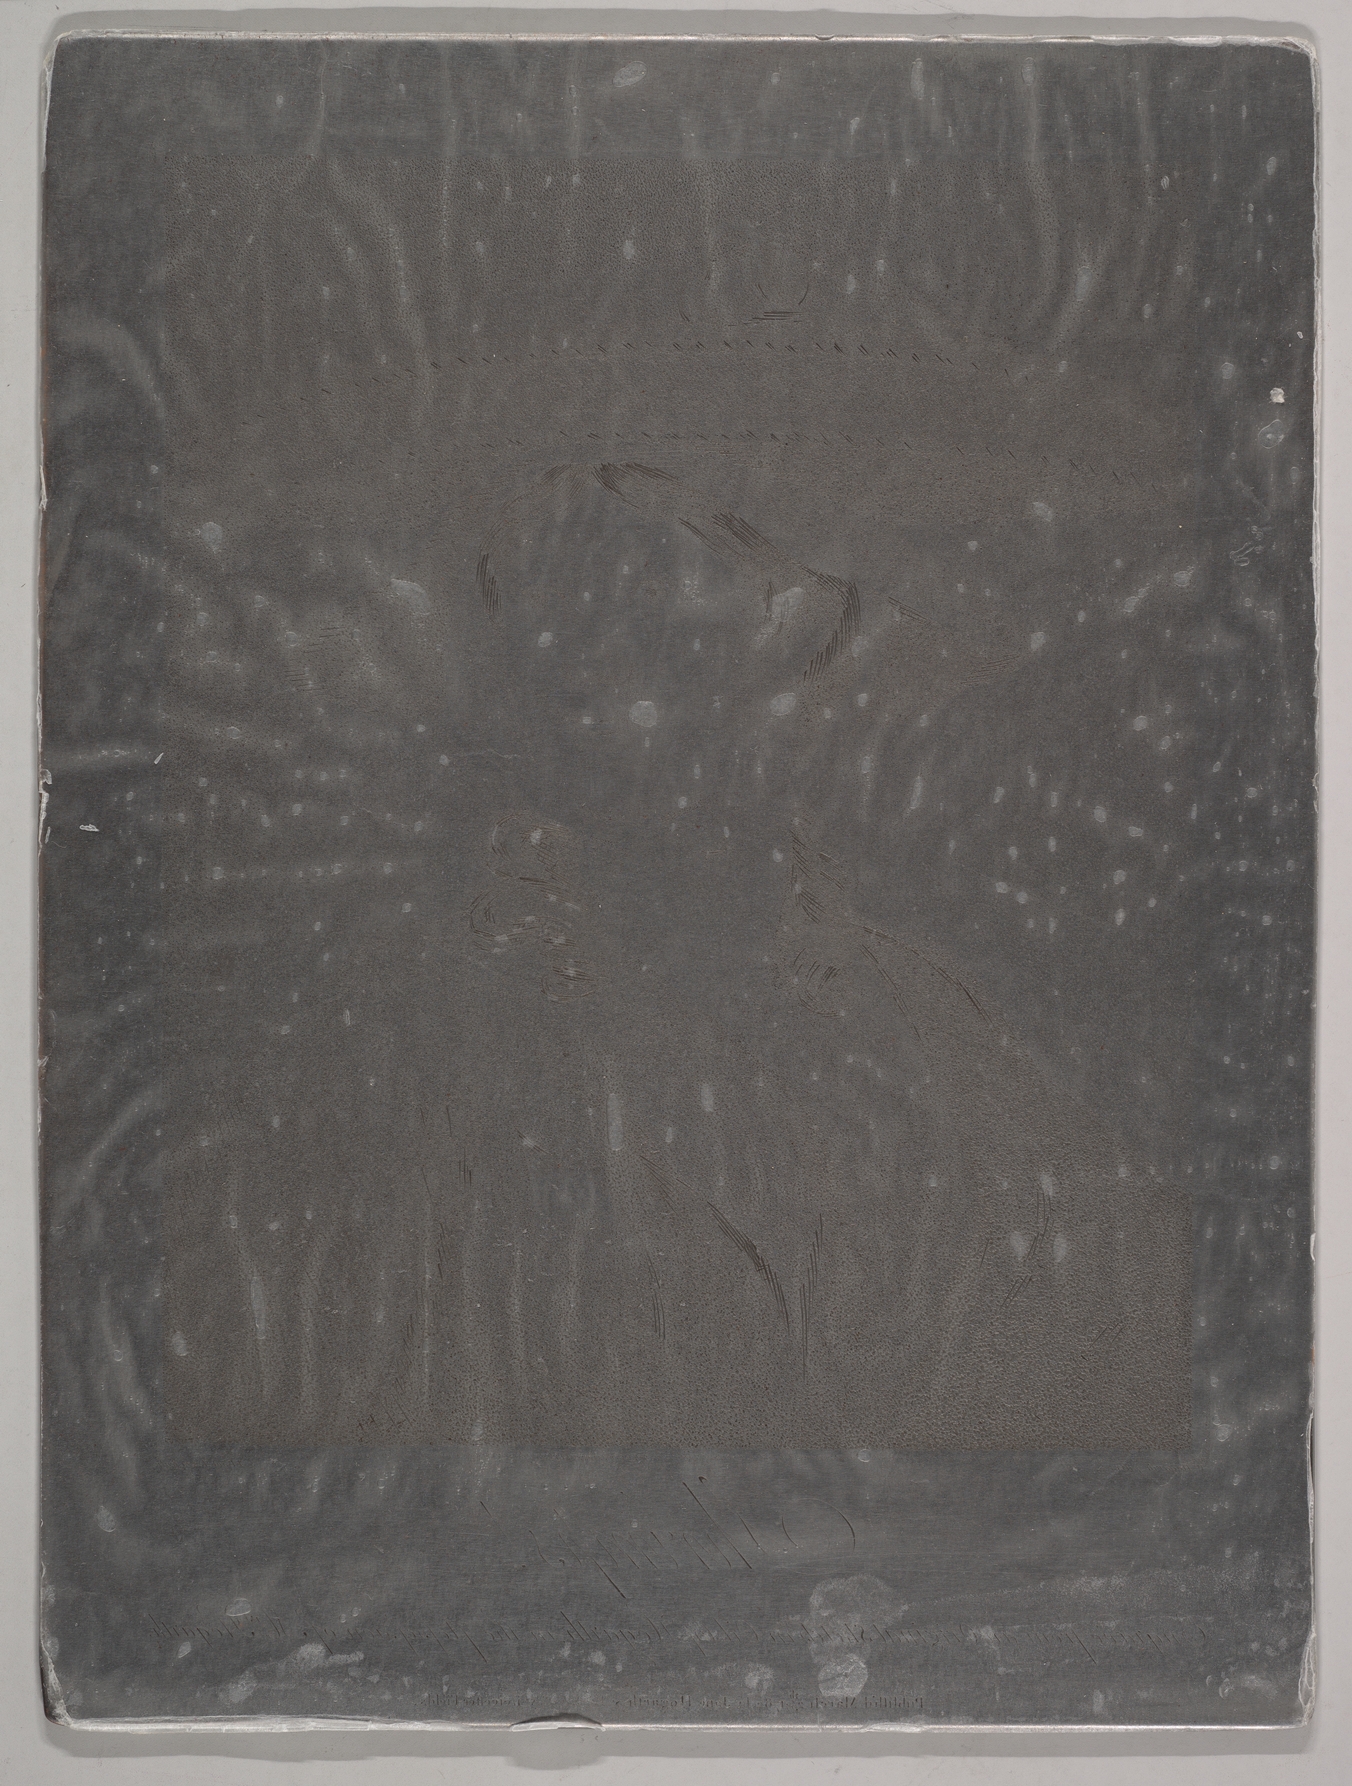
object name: plate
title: Shrimps!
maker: francesco bartolozzi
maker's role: artist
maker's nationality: italian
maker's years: 1728-1815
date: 1782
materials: copper, steel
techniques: engraving, stippling